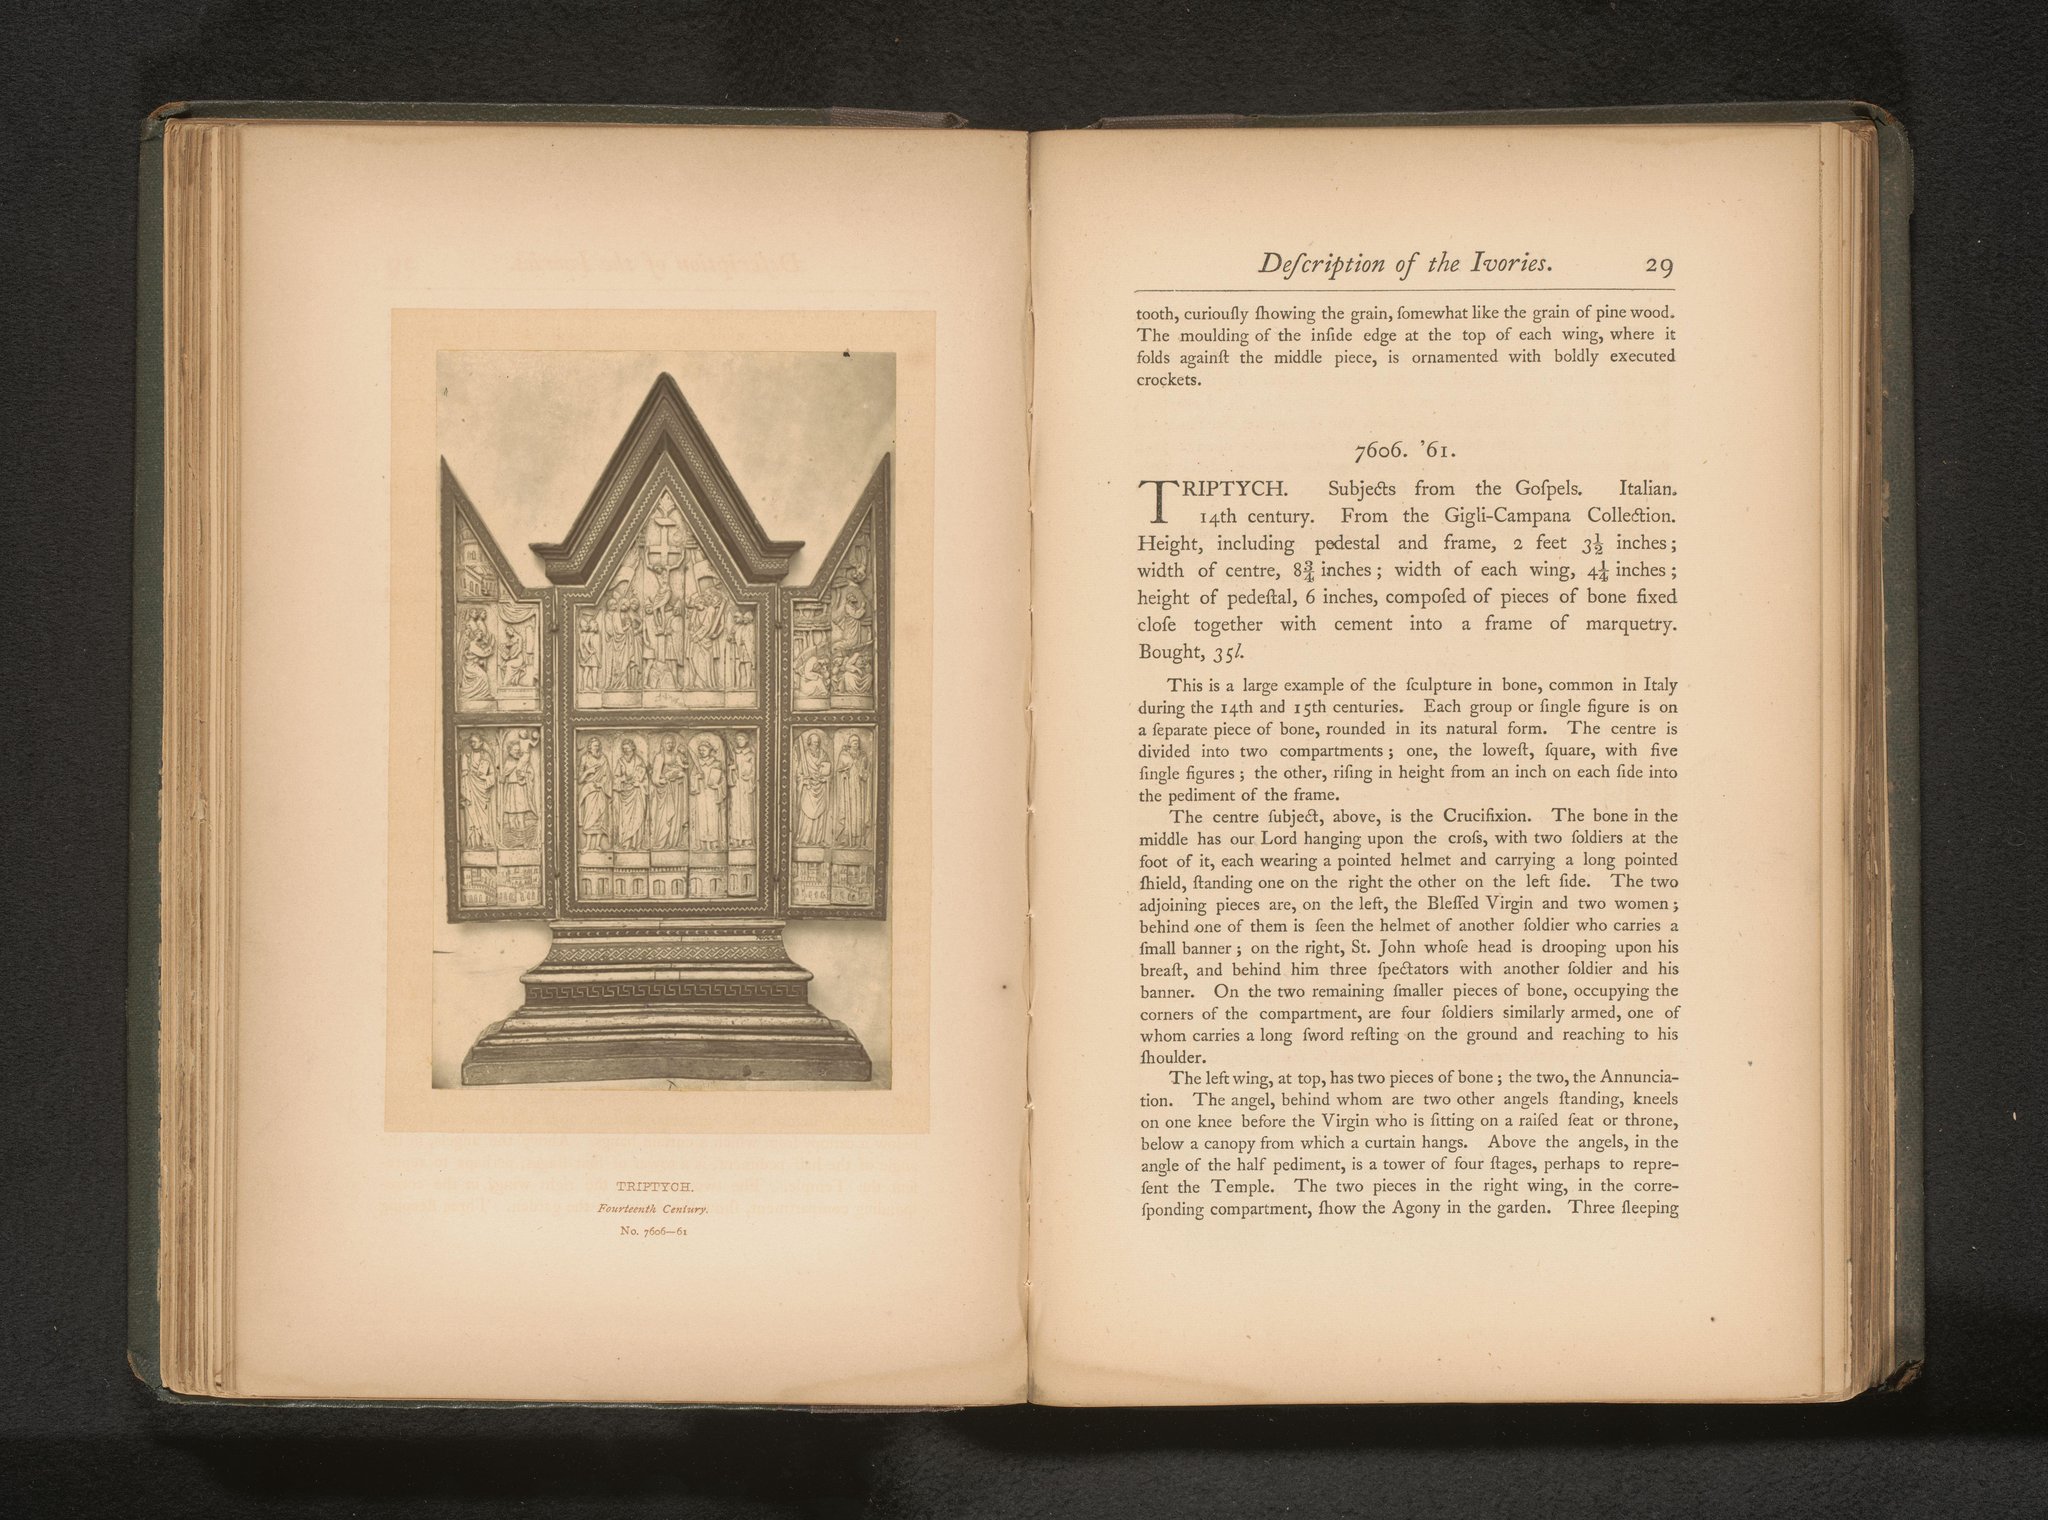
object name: page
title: Triptych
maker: Anonymous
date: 1867-1872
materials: paper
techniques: woodburytype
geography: london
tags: new testament, sculpture (+ relief ~ sculpture)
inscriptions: number: ‘No. 7606-61’, inscription: ‘Fourteenth Century.’